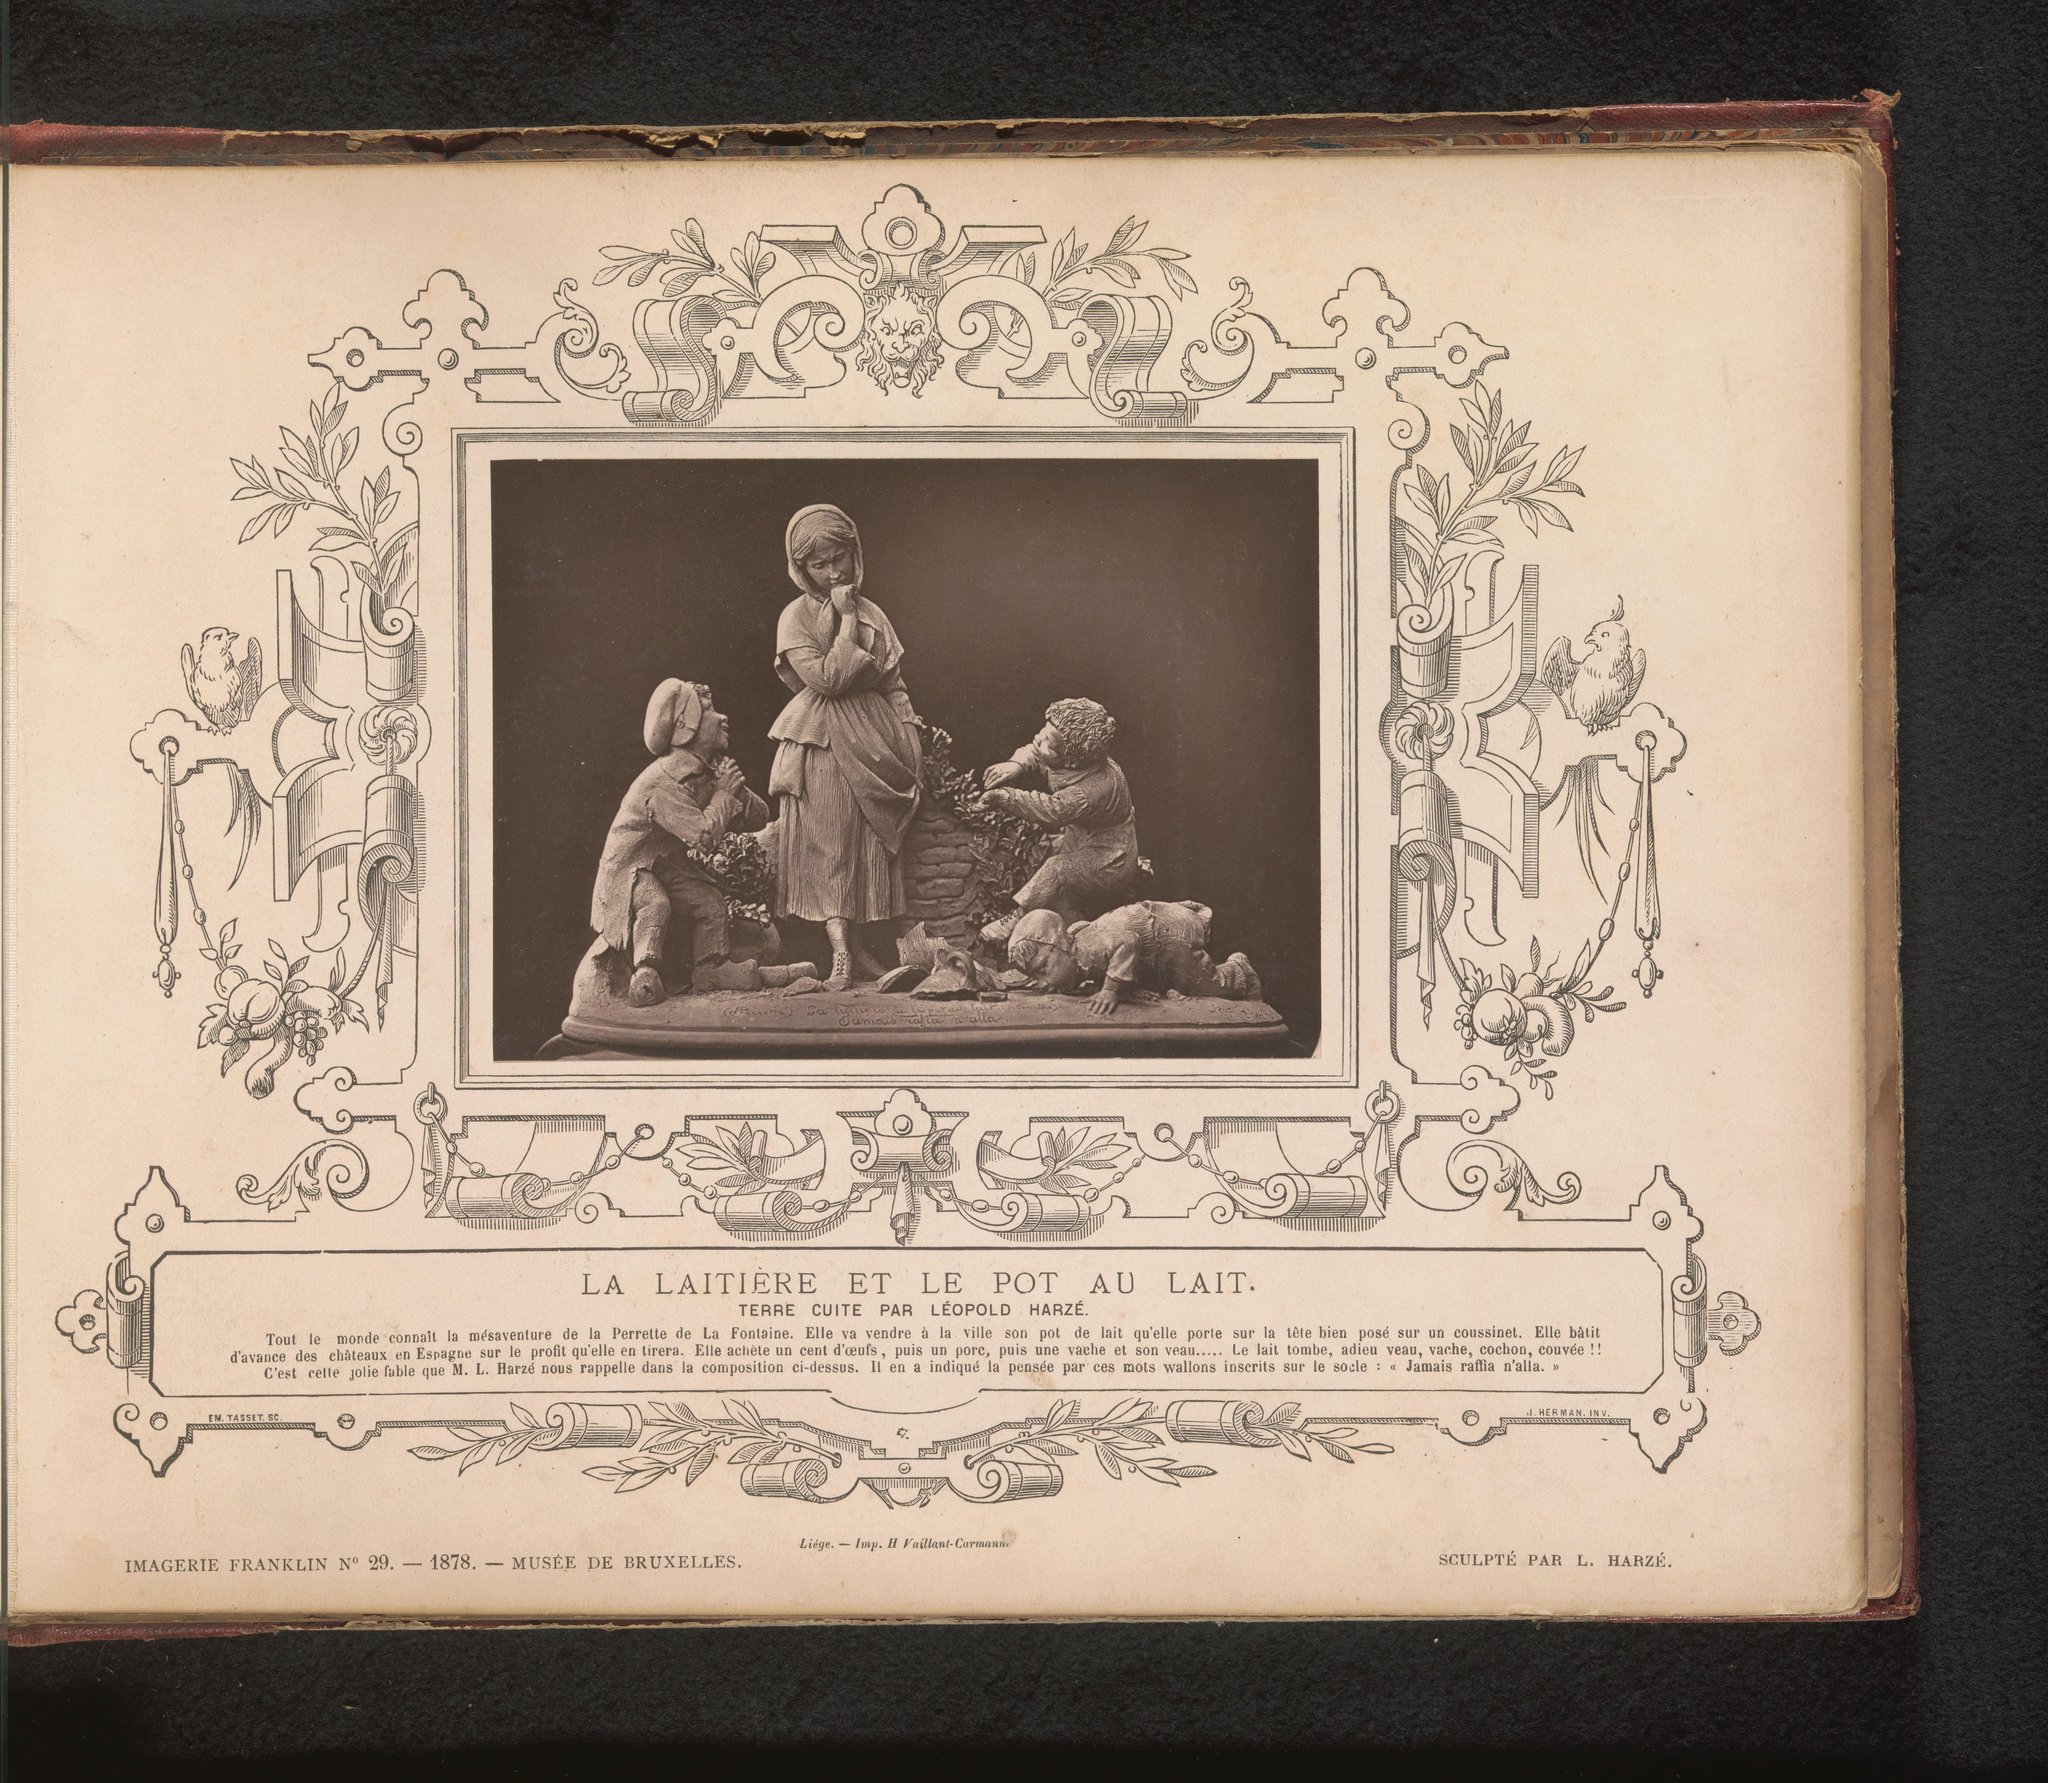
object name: photomechanical print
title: La Laitière et le Pot au Lait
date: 1873-1878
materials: paper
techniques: woodburytype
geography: liège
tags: piece of sculpture, reproduction of a piece of sculpture, fables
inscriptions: name: ‘EM. TASSET, SC.’, inscription: ‘SCULPTÉ PAR L. HARZÉ.’, inscription: ‘TERRE CUITE (...) raffia n'alla.>>’, name: ‘J. HERMAN, INV.’, inscription: ‘IMAGERIE FRANKLIN No 29. -1878. - MUSÉE DE BRUXELLES.’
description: Deze prent maakt deel uit van een album.